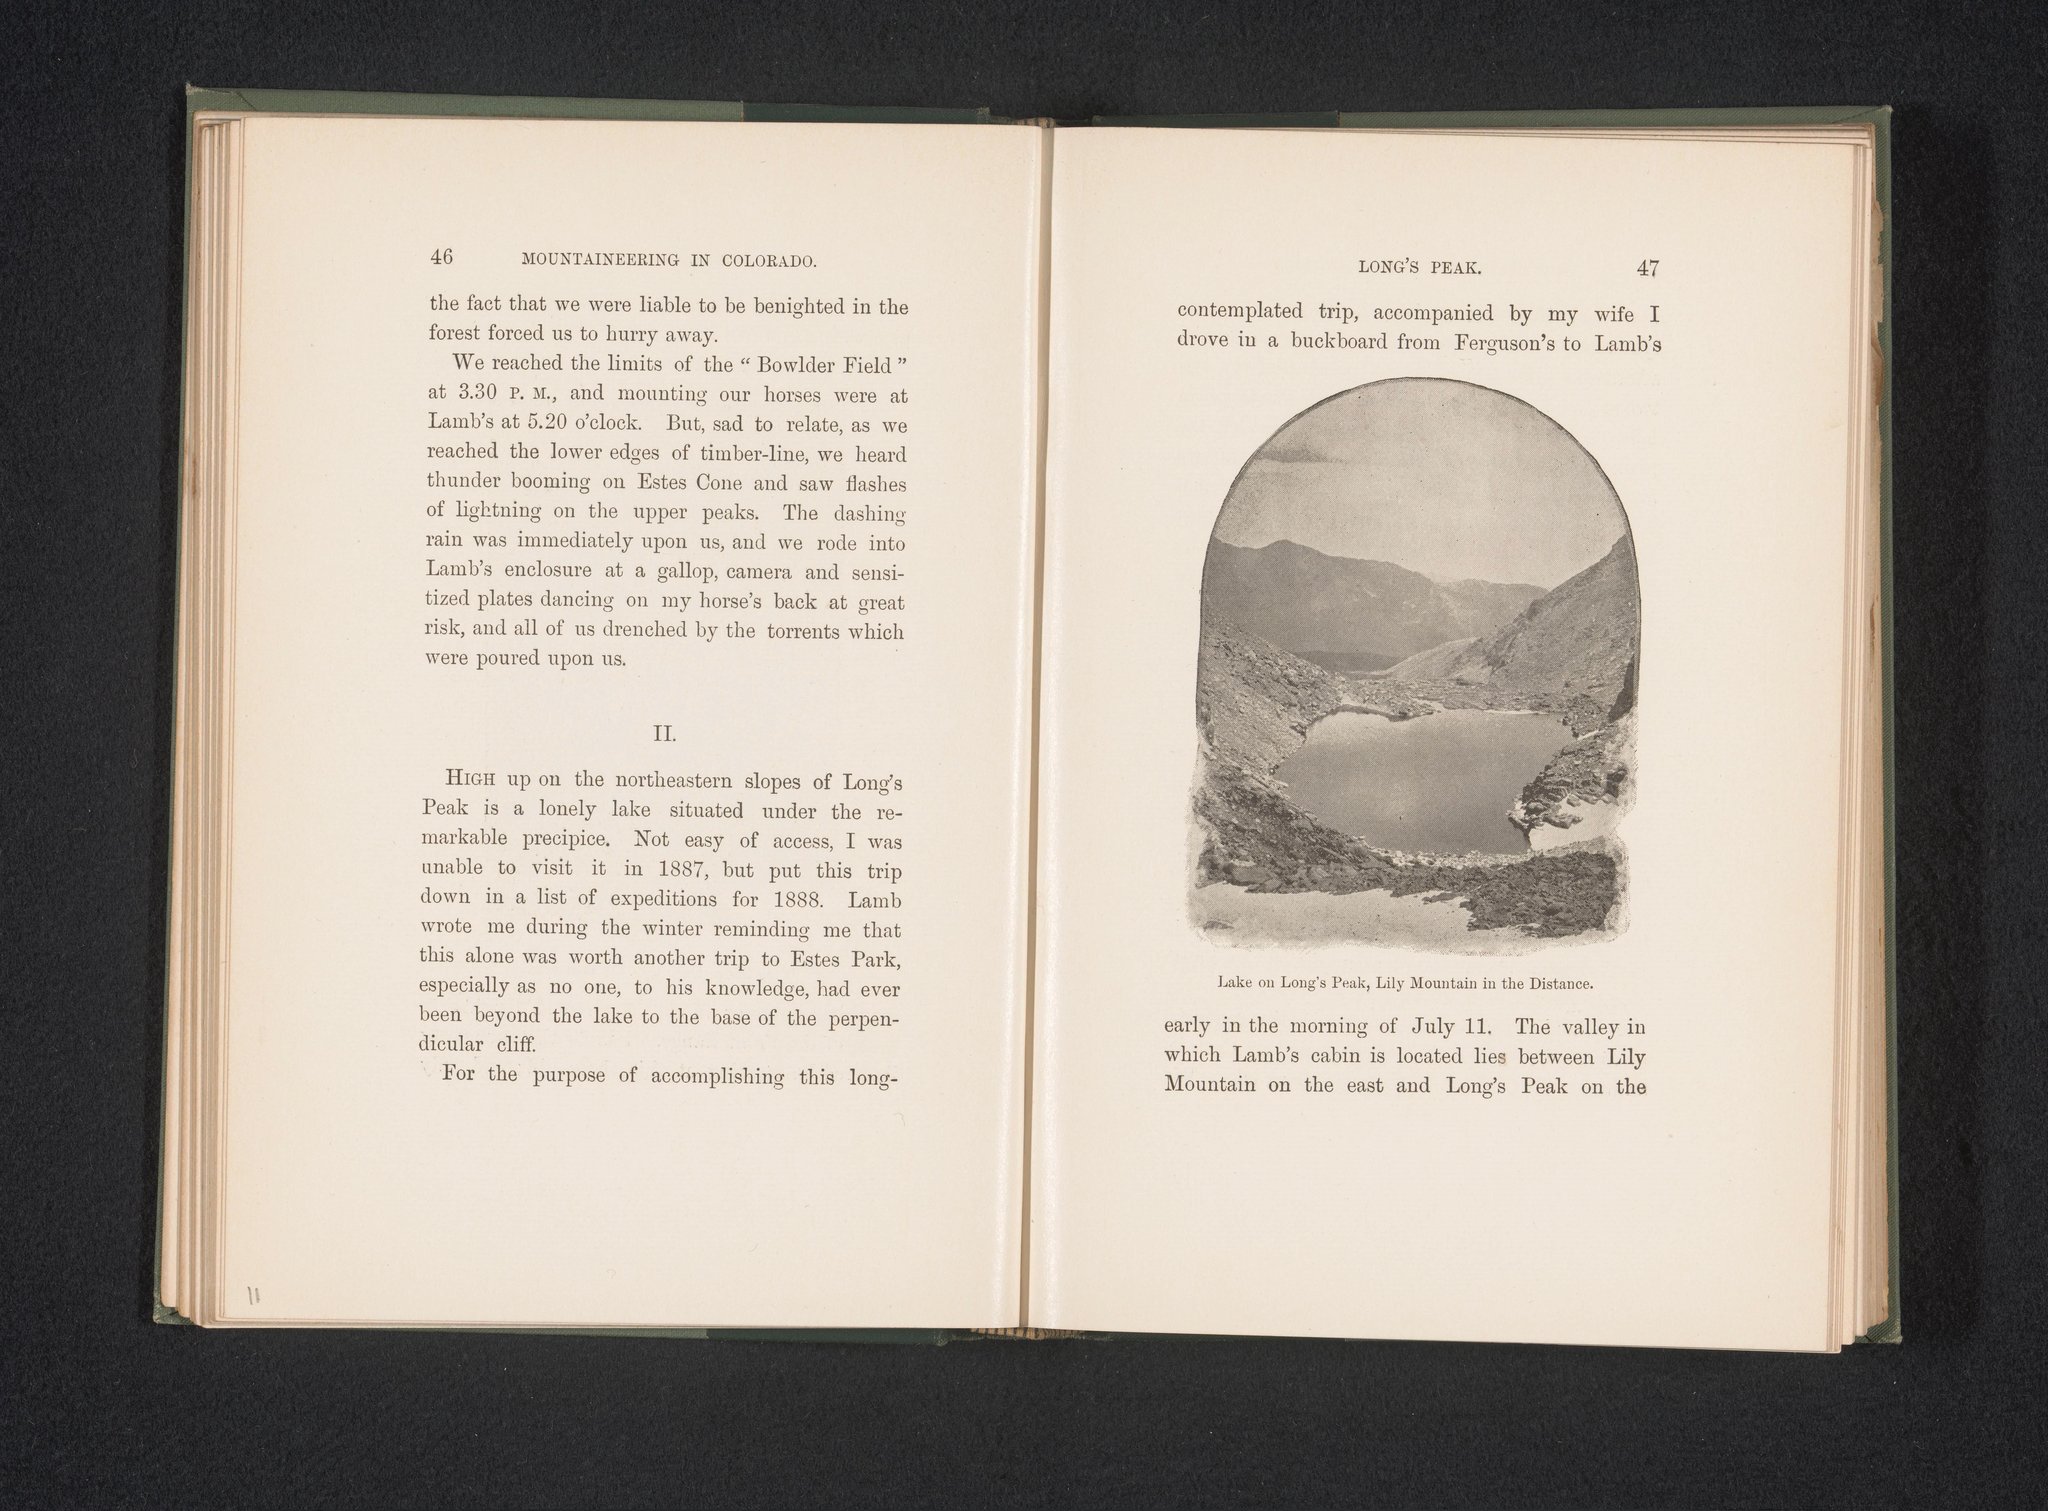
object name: page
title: Gezicht op Chasm Lake en Lily Mountain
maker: frederick hastings chapin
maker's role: antropoloog, archeoloog, fotograaf, schrijver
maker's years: 1852-1900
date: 1885-1890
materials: paper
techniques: autotype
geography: rocky mountain national park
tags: wildlife reserve, national park, lake, mountains